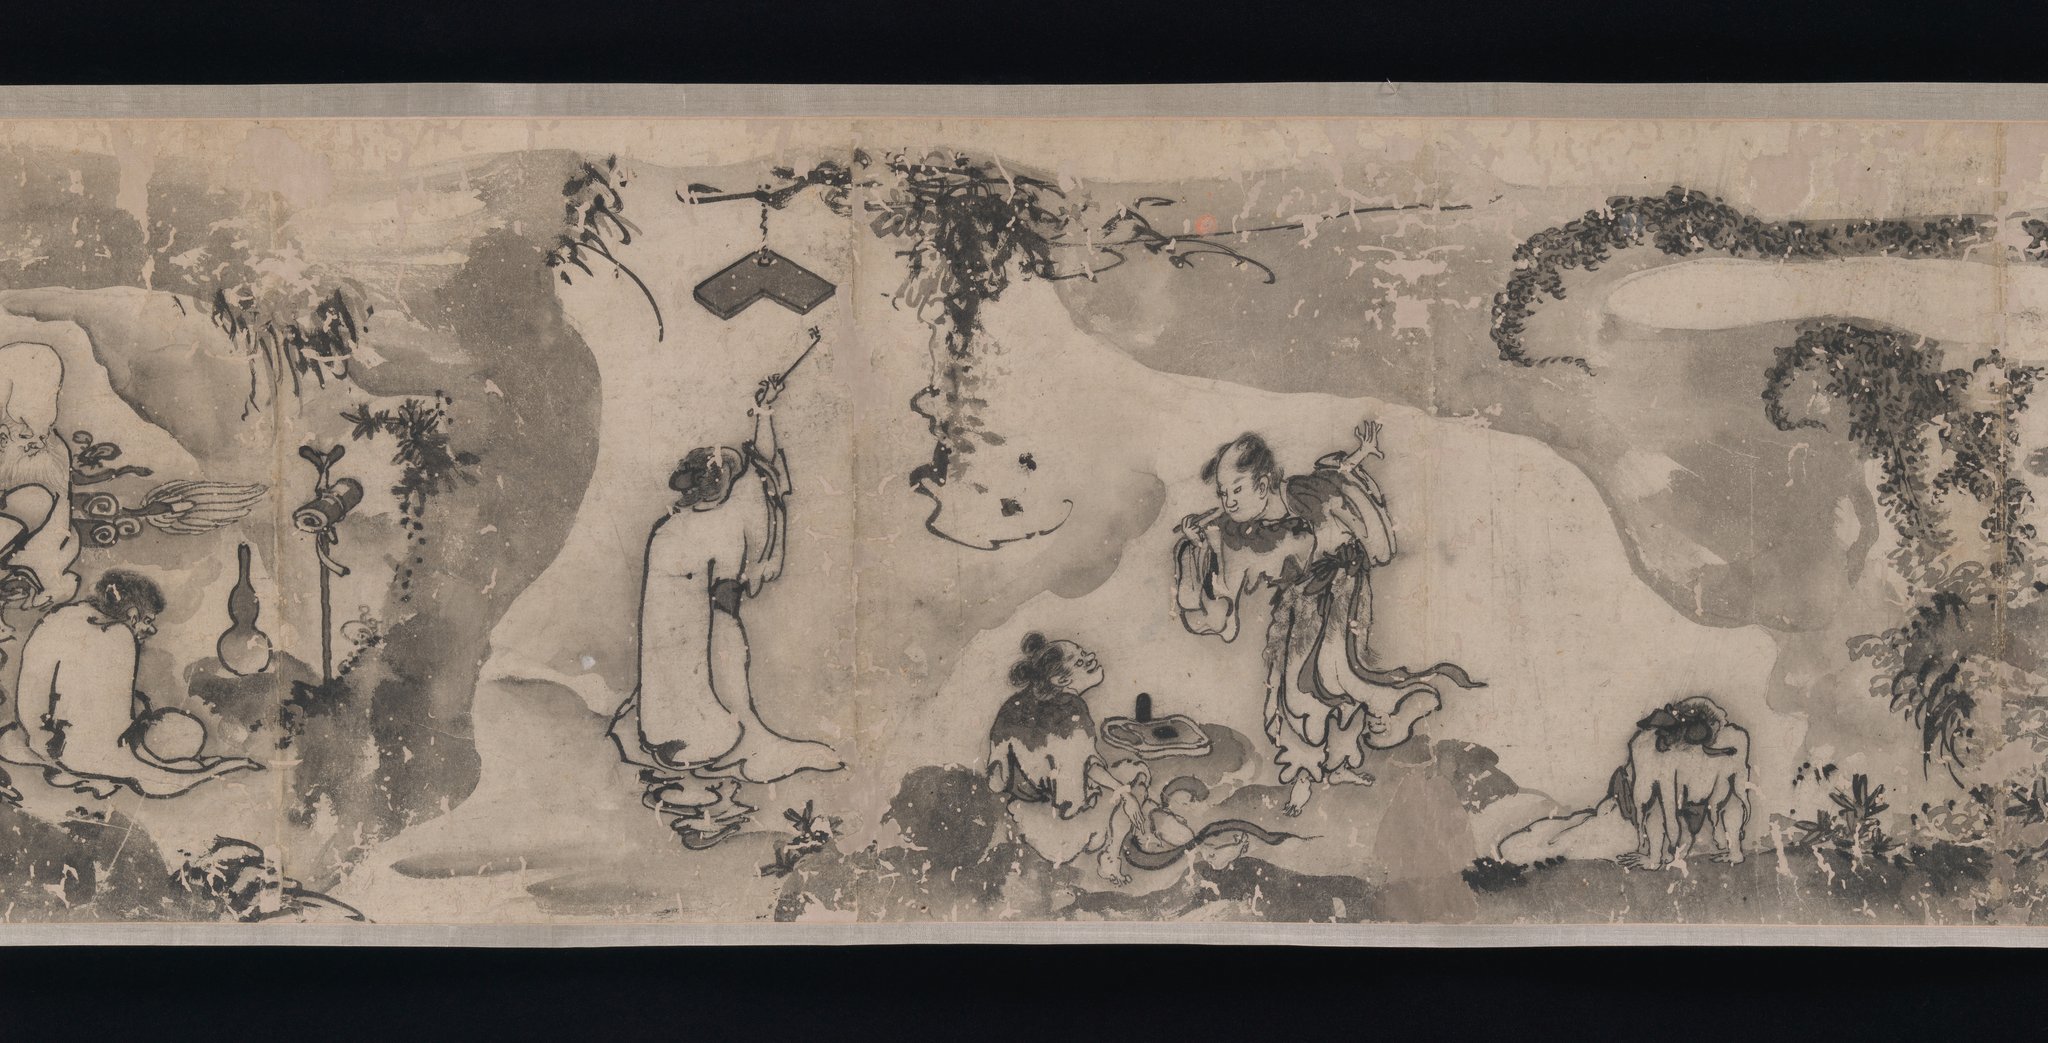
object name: handscroll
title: Merry Gatherings in the Magic Jar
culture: chinese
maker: gong kai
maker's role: artist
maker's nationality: chinese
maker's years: 1222-1310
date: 1222-1279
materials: ink, paper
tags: men,landscapes